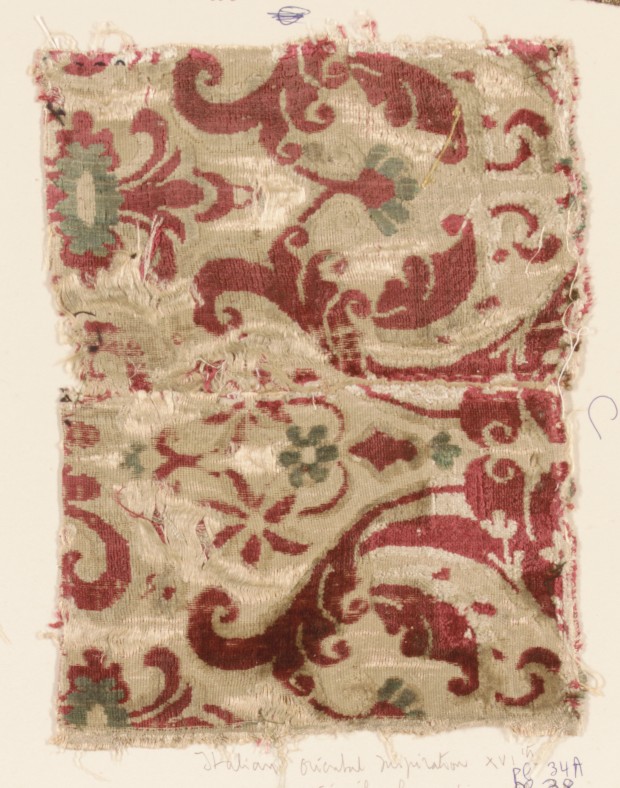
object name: fragment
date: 1501-1533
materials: silk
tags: flowers